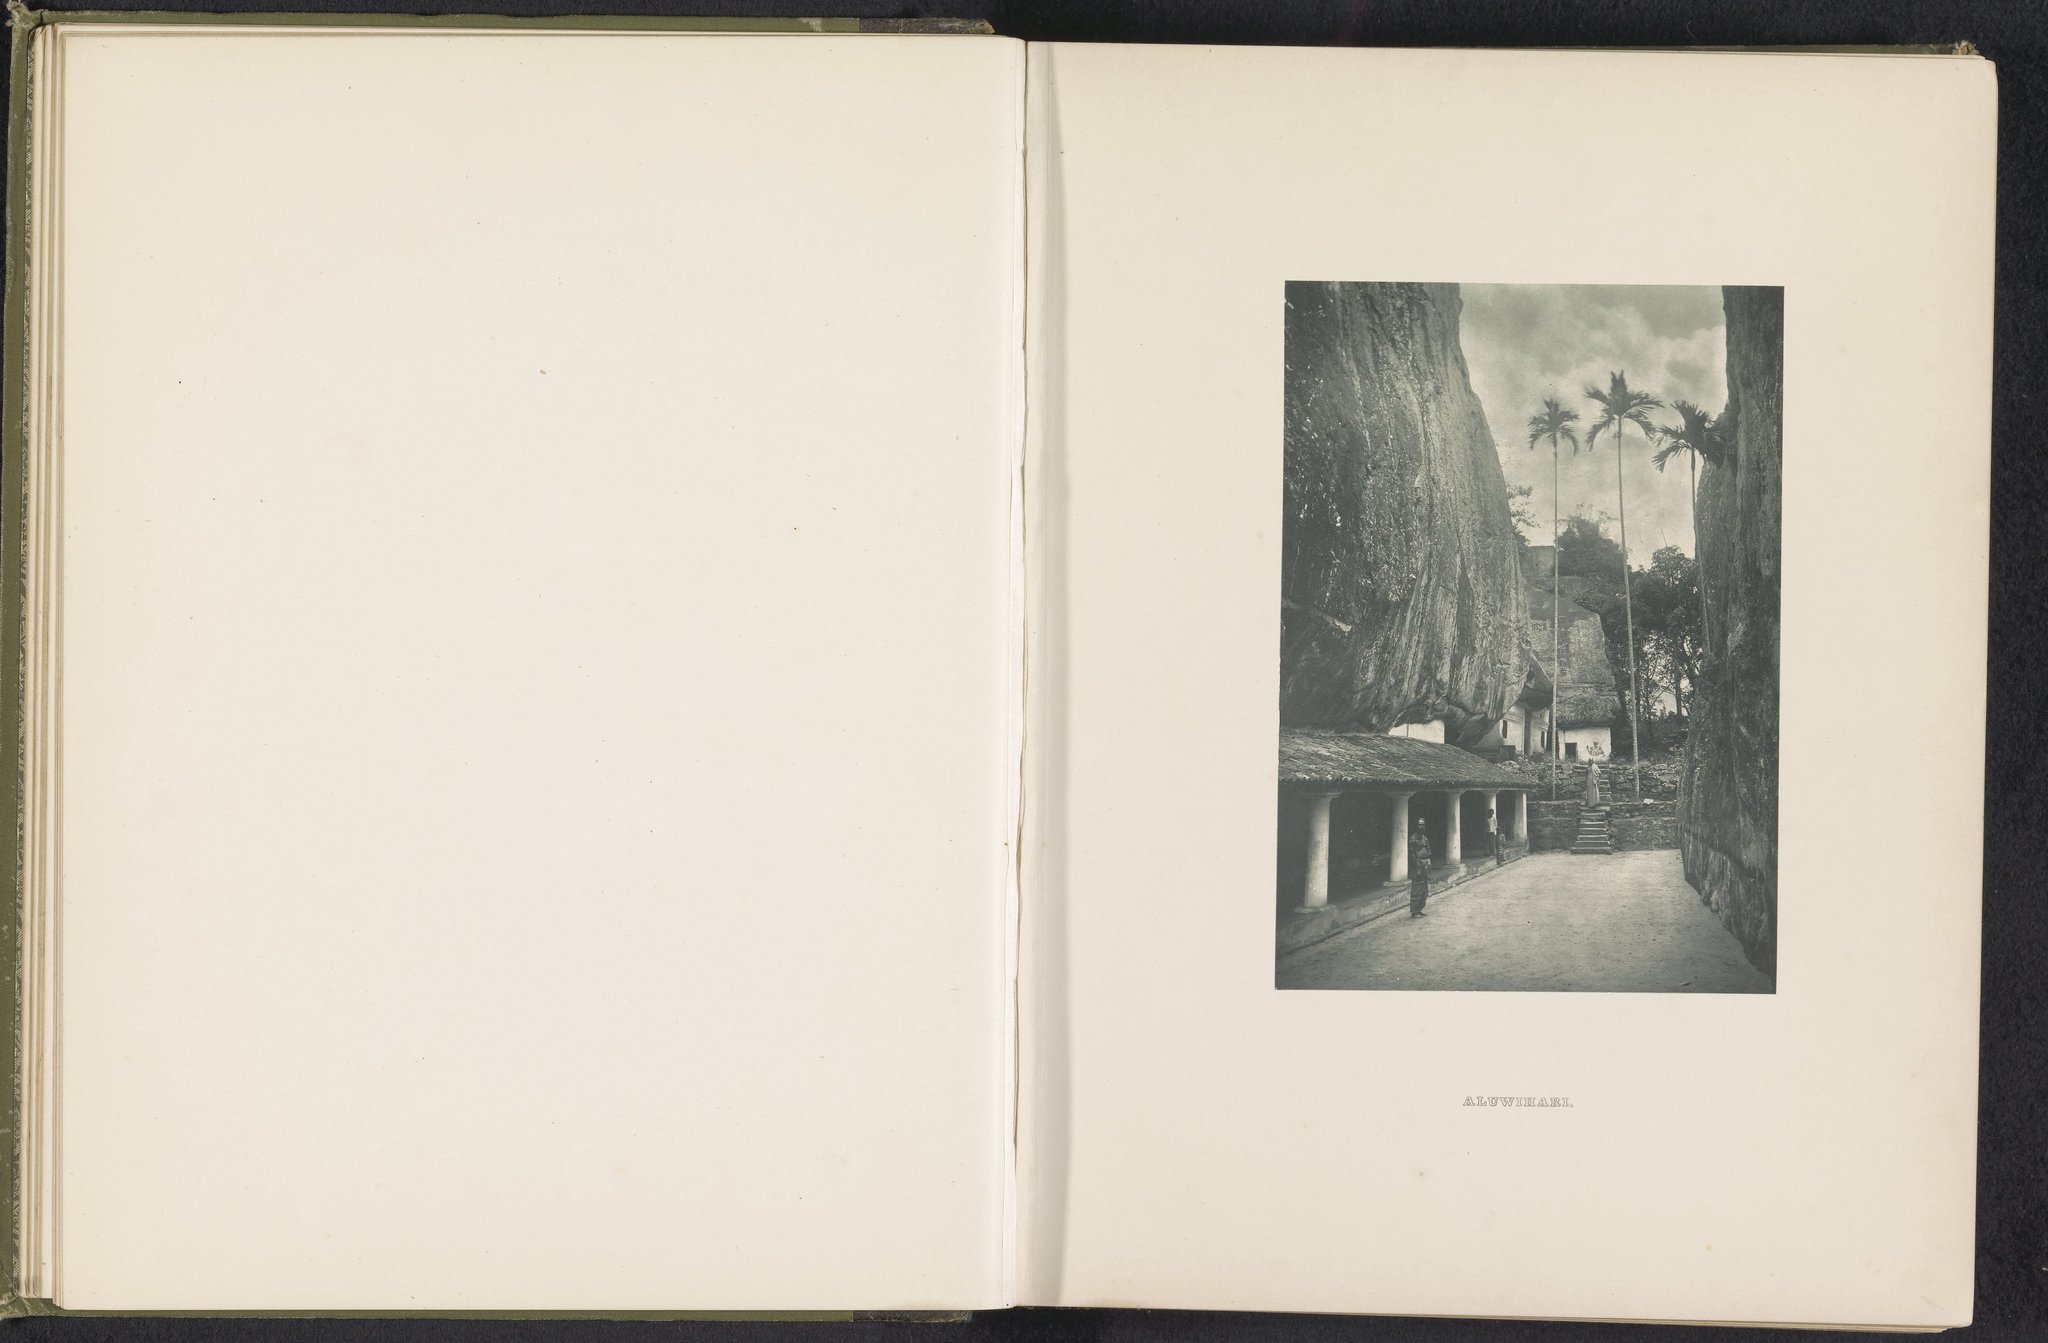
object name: photomechanical print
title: Aluvihare Rock Temple, Sri Lanka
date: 1896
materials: paper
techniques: woodburygravure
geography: aluvihare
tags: temple, shrine ~ hinduism, buddhism, jainism, rock-formations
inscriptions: title: ‘ALUWIHARI.’